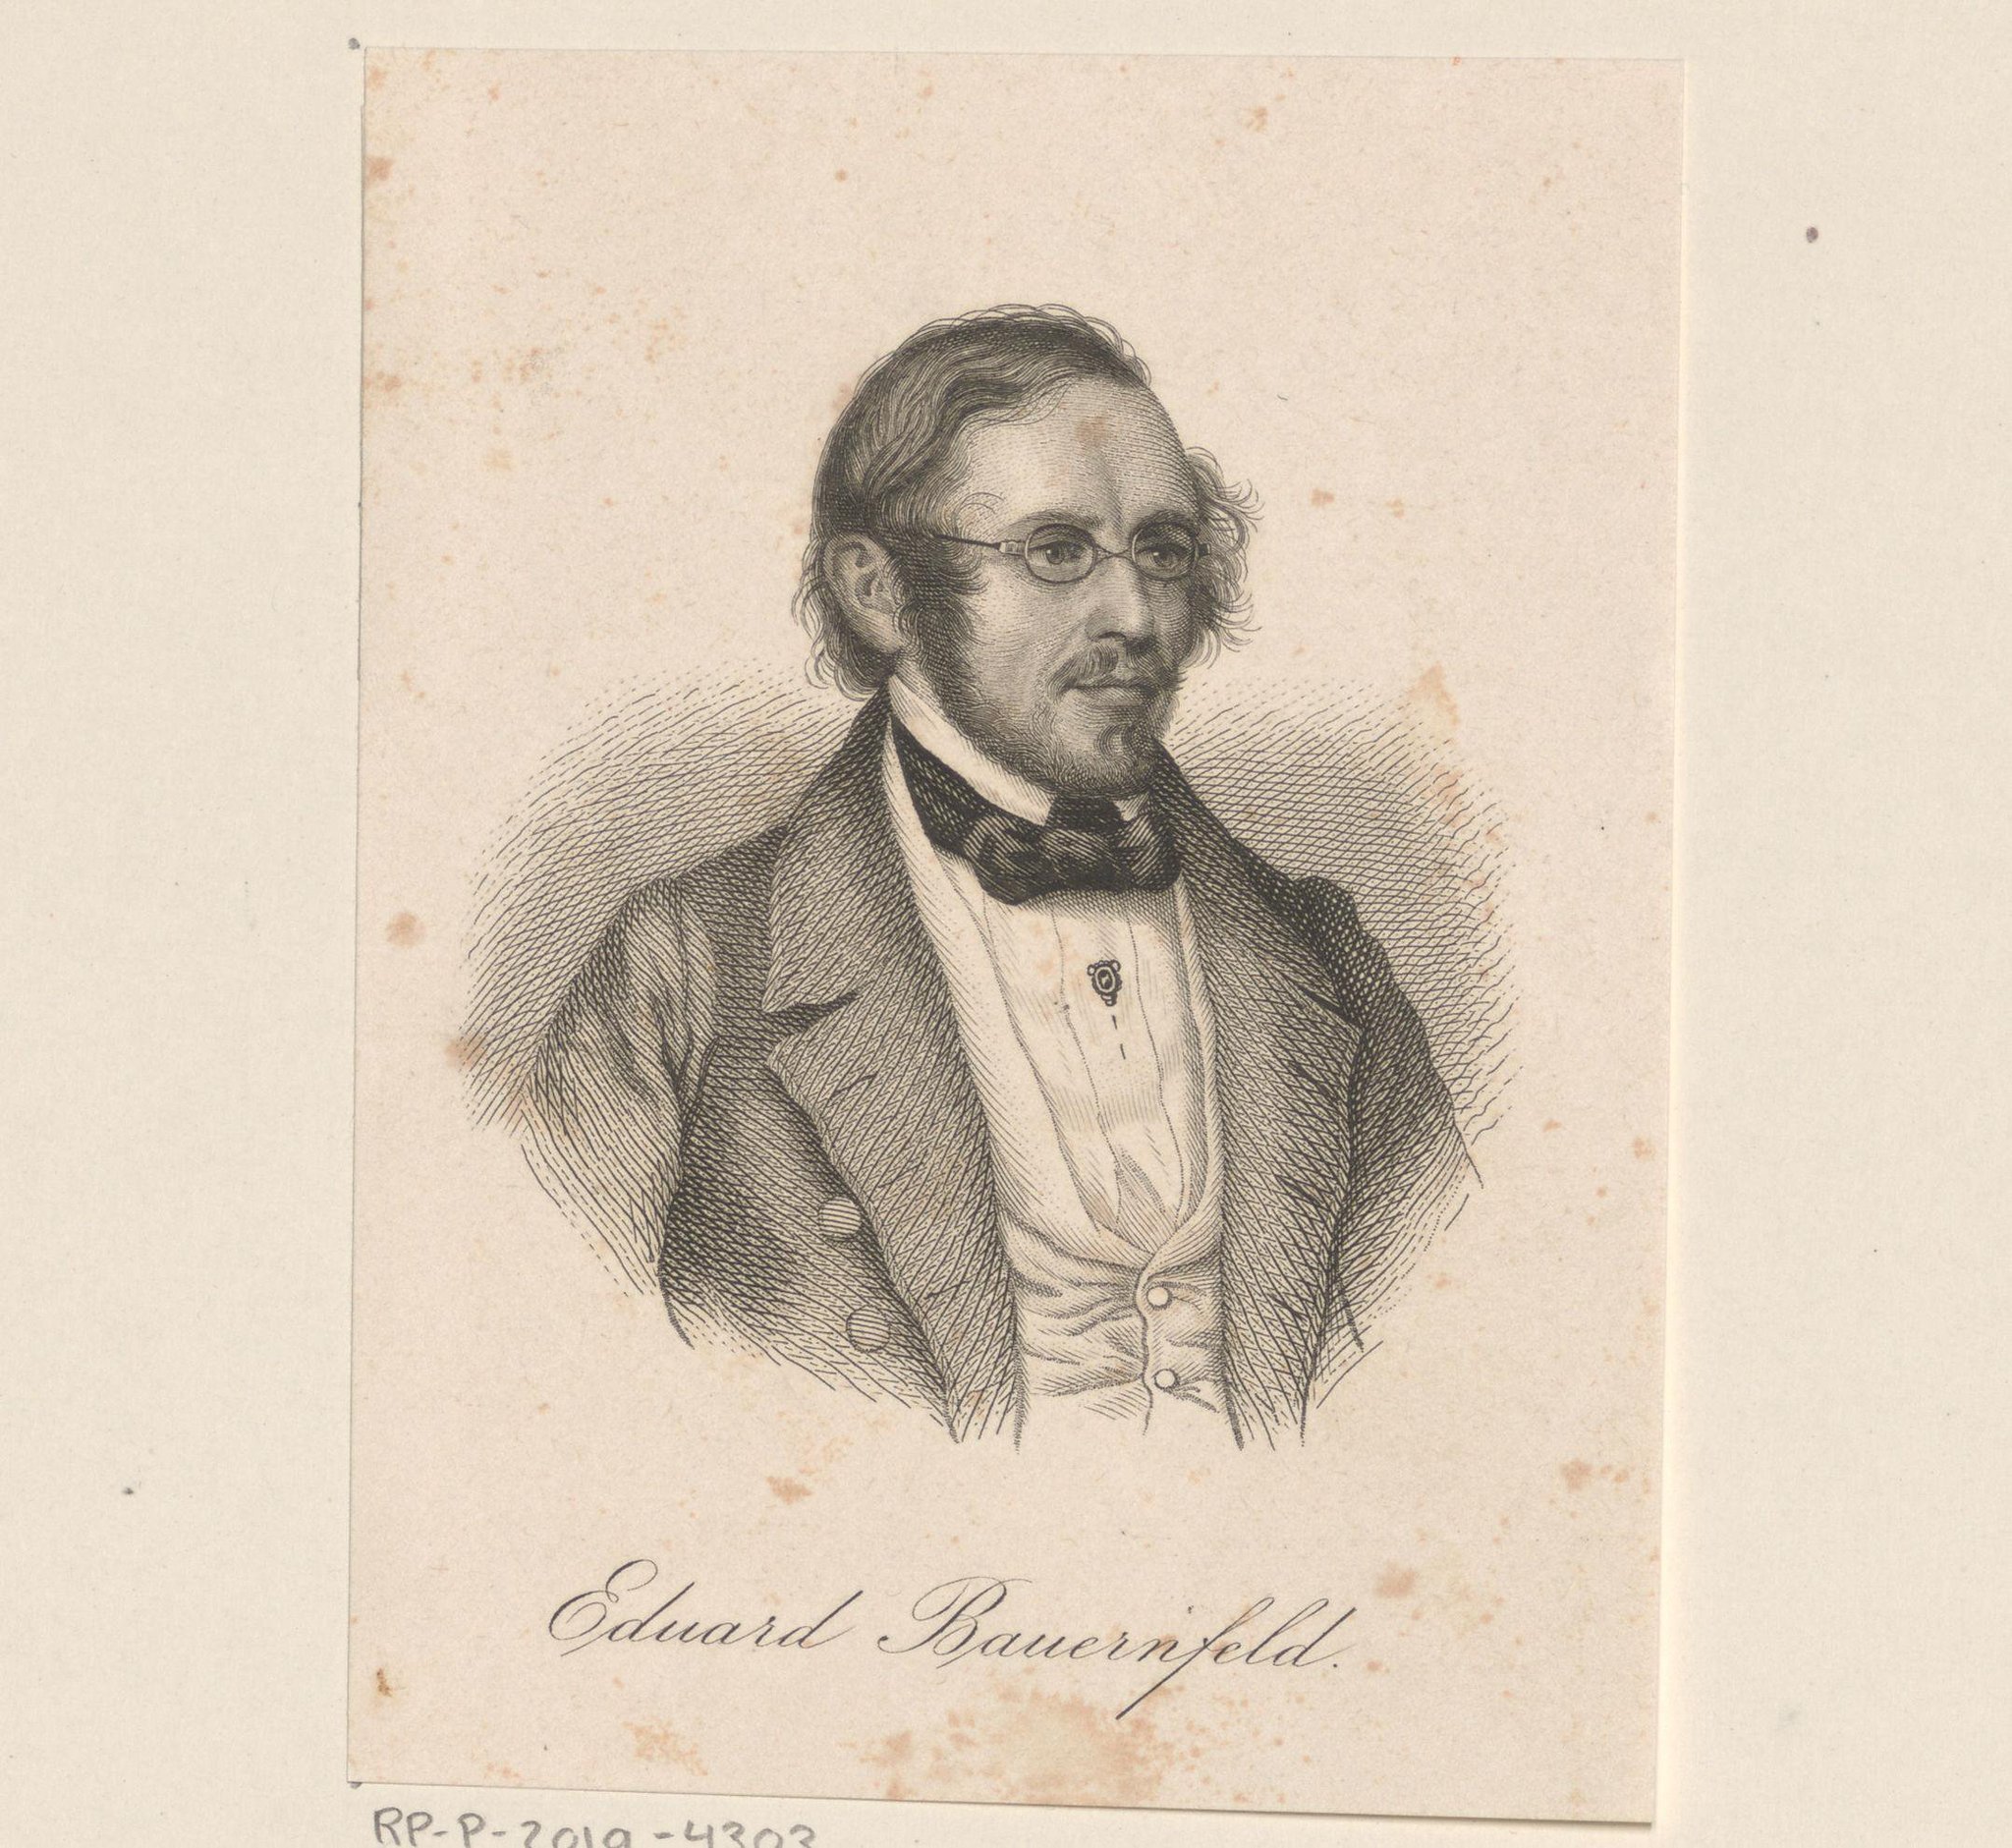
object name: print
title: Portret van Eduard von Bauernfeld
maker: Anonymous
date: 1850-1899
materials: paper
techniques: engraving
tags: vienna, vienna state, historical persons, writer, poet, author